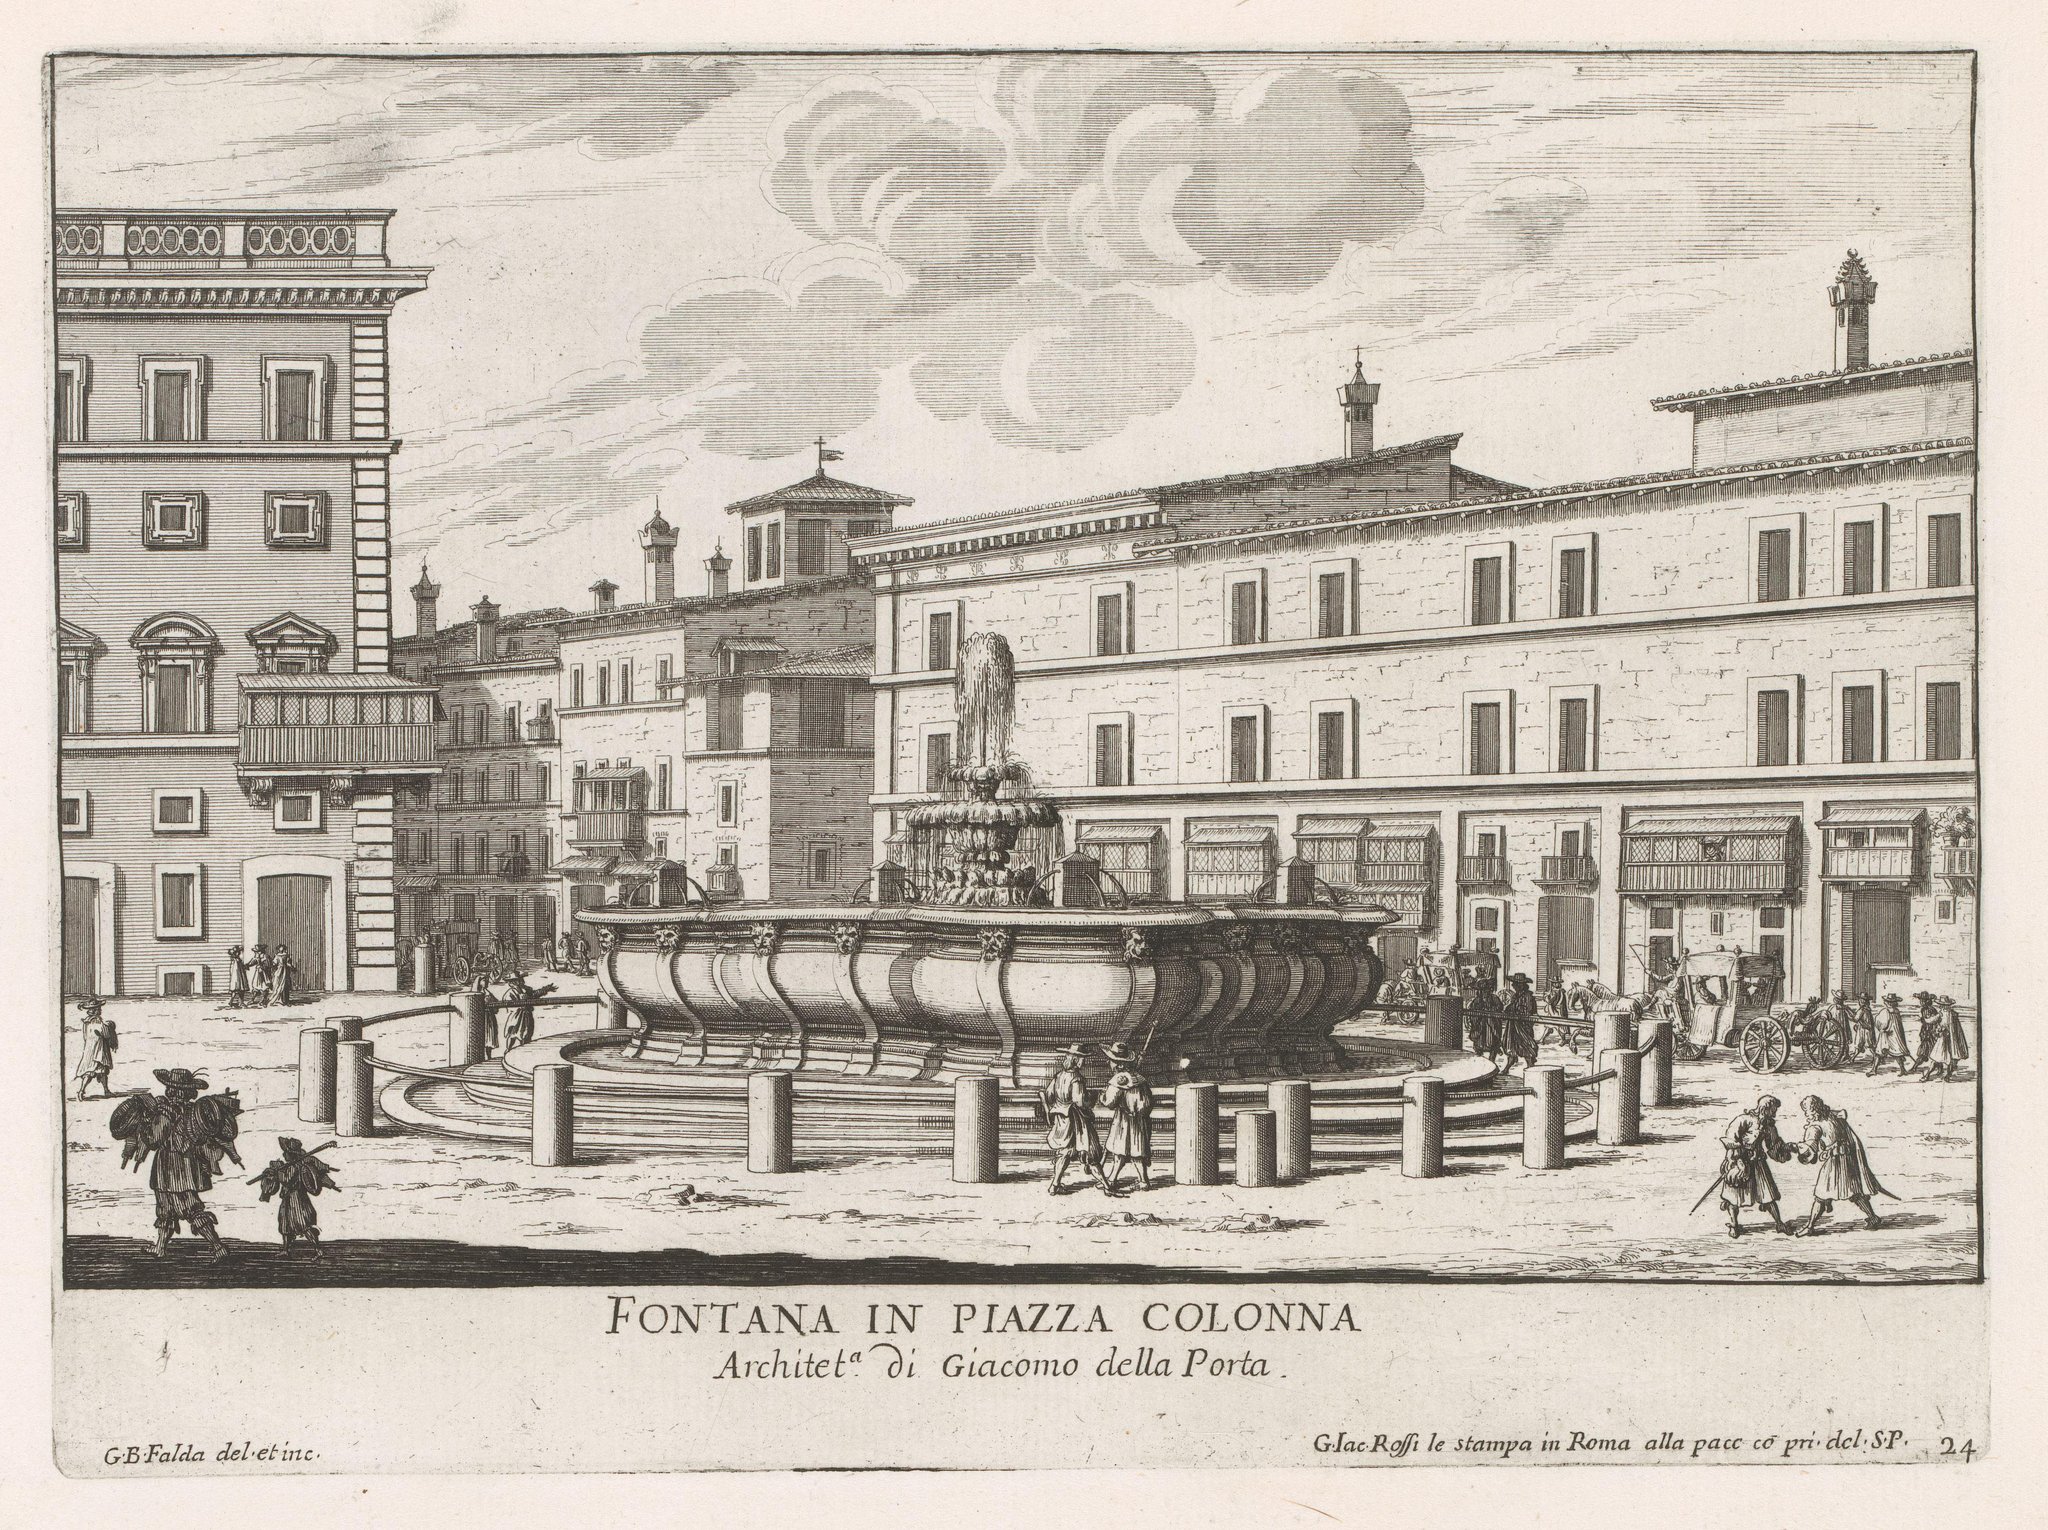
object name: album leaf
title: Fontein op Piazza Colonna te Rome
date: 1653-1691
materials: paper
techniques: etching, intaglio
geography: rome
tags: ornamental fountain, rome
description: Genummerd rechtsonder: 24. De prent maakt deel uit van een album.